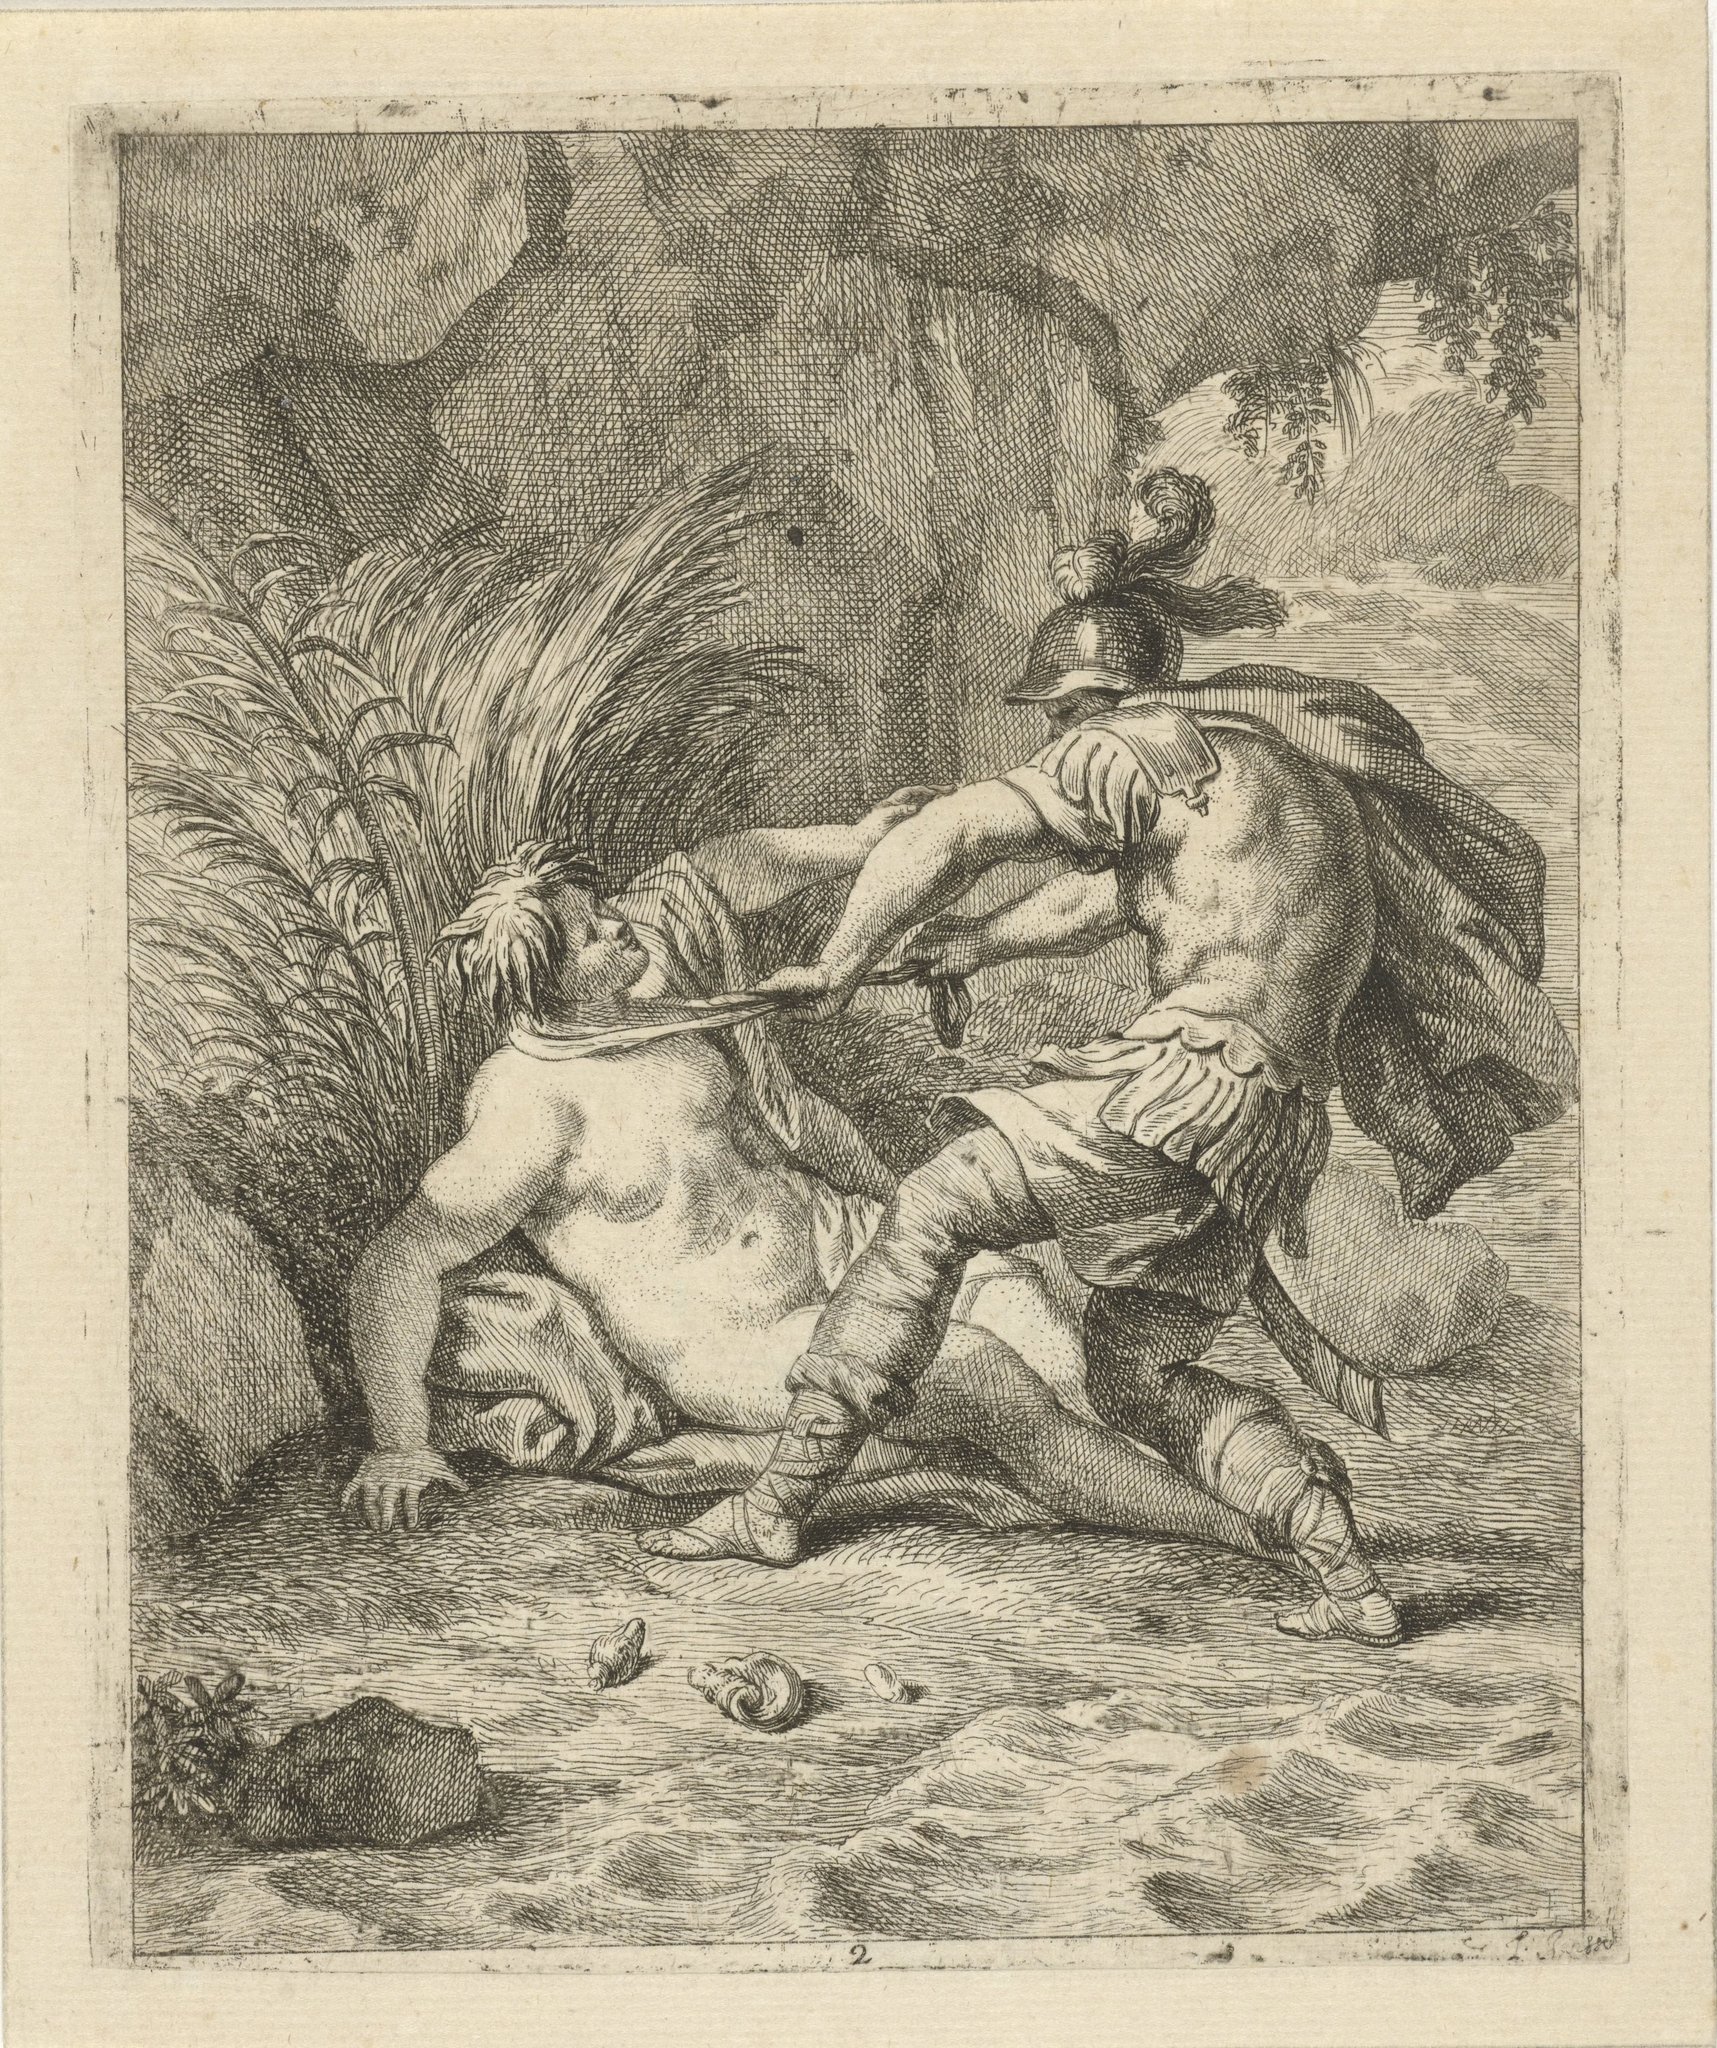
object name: print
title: Scènes uit het leven van Achilles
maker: j. alexander janssens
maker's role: print maker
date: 1700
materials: paper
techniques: engraving, etching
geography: southern netherlands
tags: (story of) peleus and thetis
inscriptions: collector's mark: Lugt 2228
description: Peleus, in harnas, vangt de waternimf Thetis met een doek om haar hals. Thetis ligt aan de waterkant, tegen het riet aan. Midden onder: 2. Tweede prent uit een serie van veertien met scènes uit het leven van Achilles.